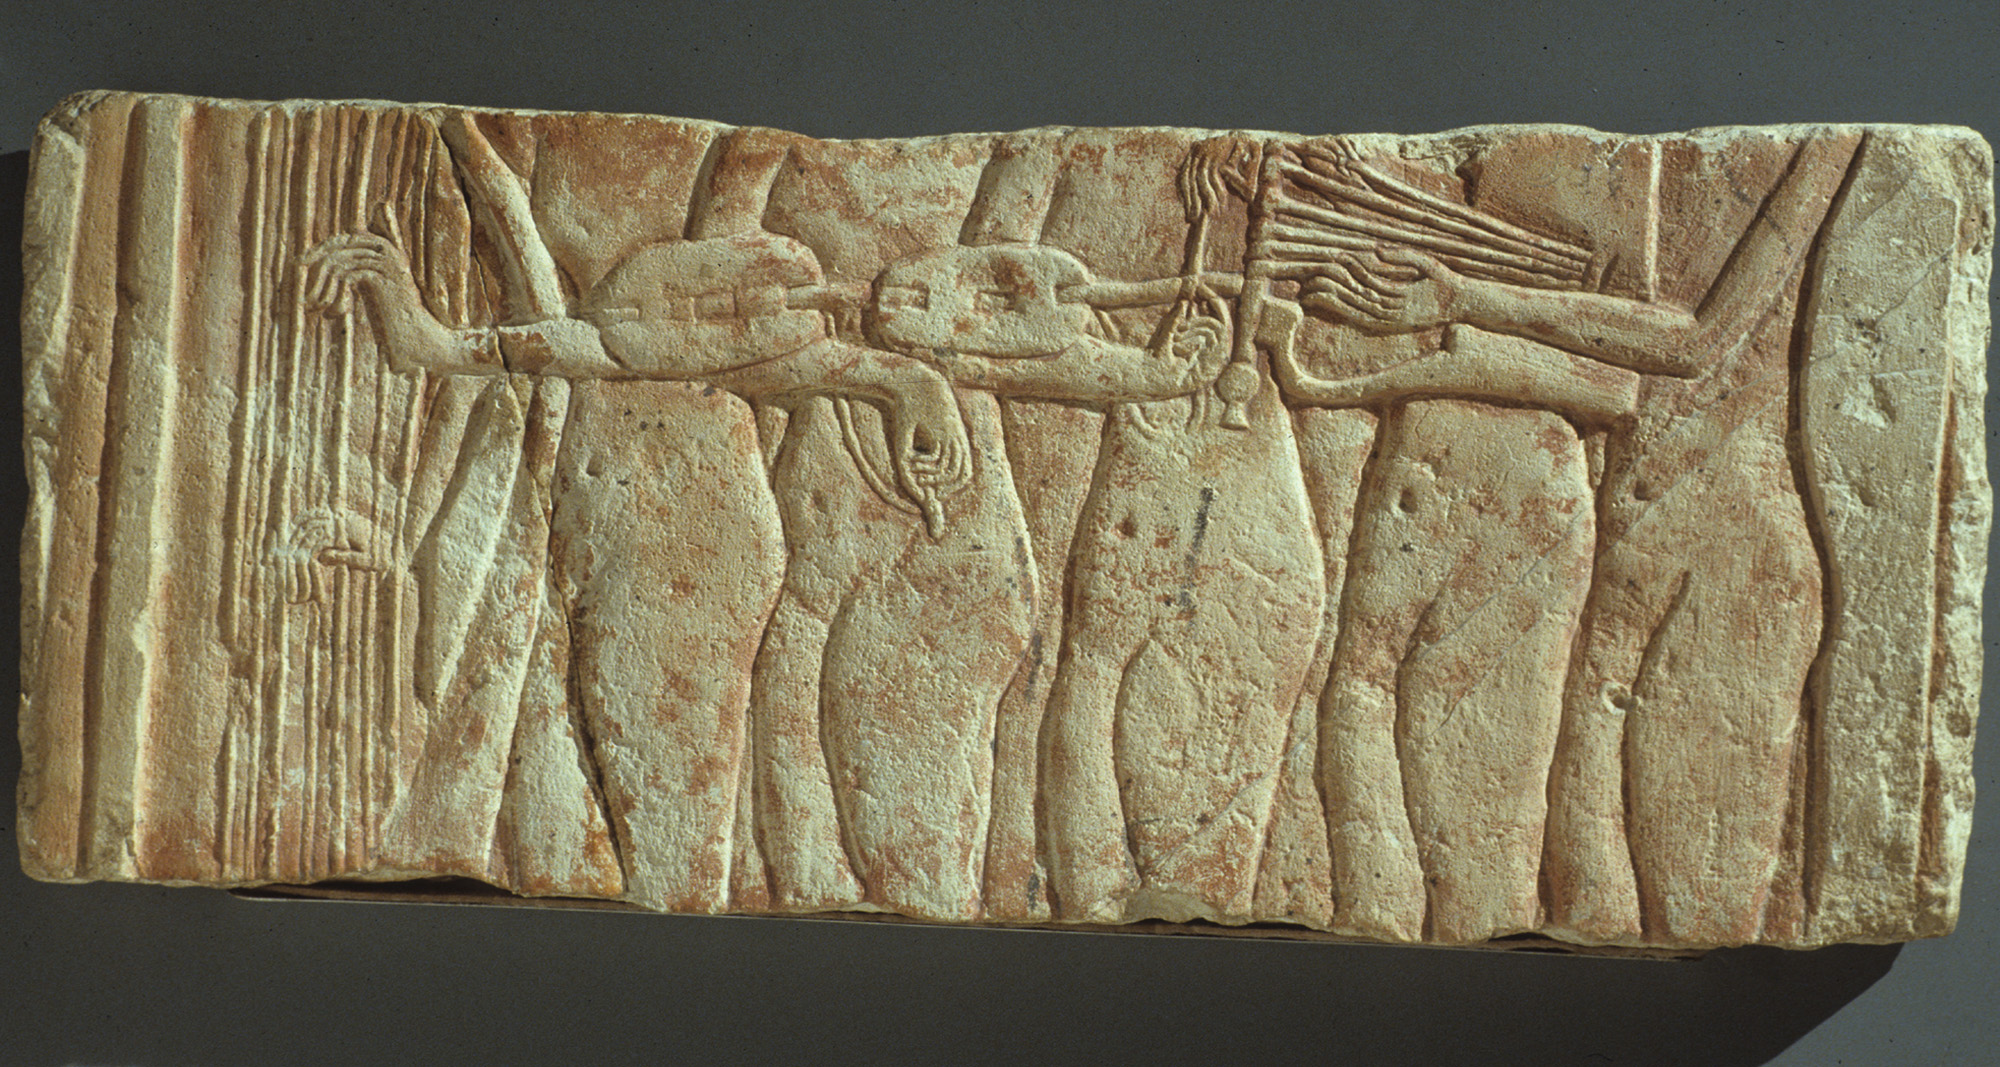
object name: talatat, musician, woman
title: Female Musicians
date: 1353-1336 BCE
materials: limestone, paint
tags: women,musicians